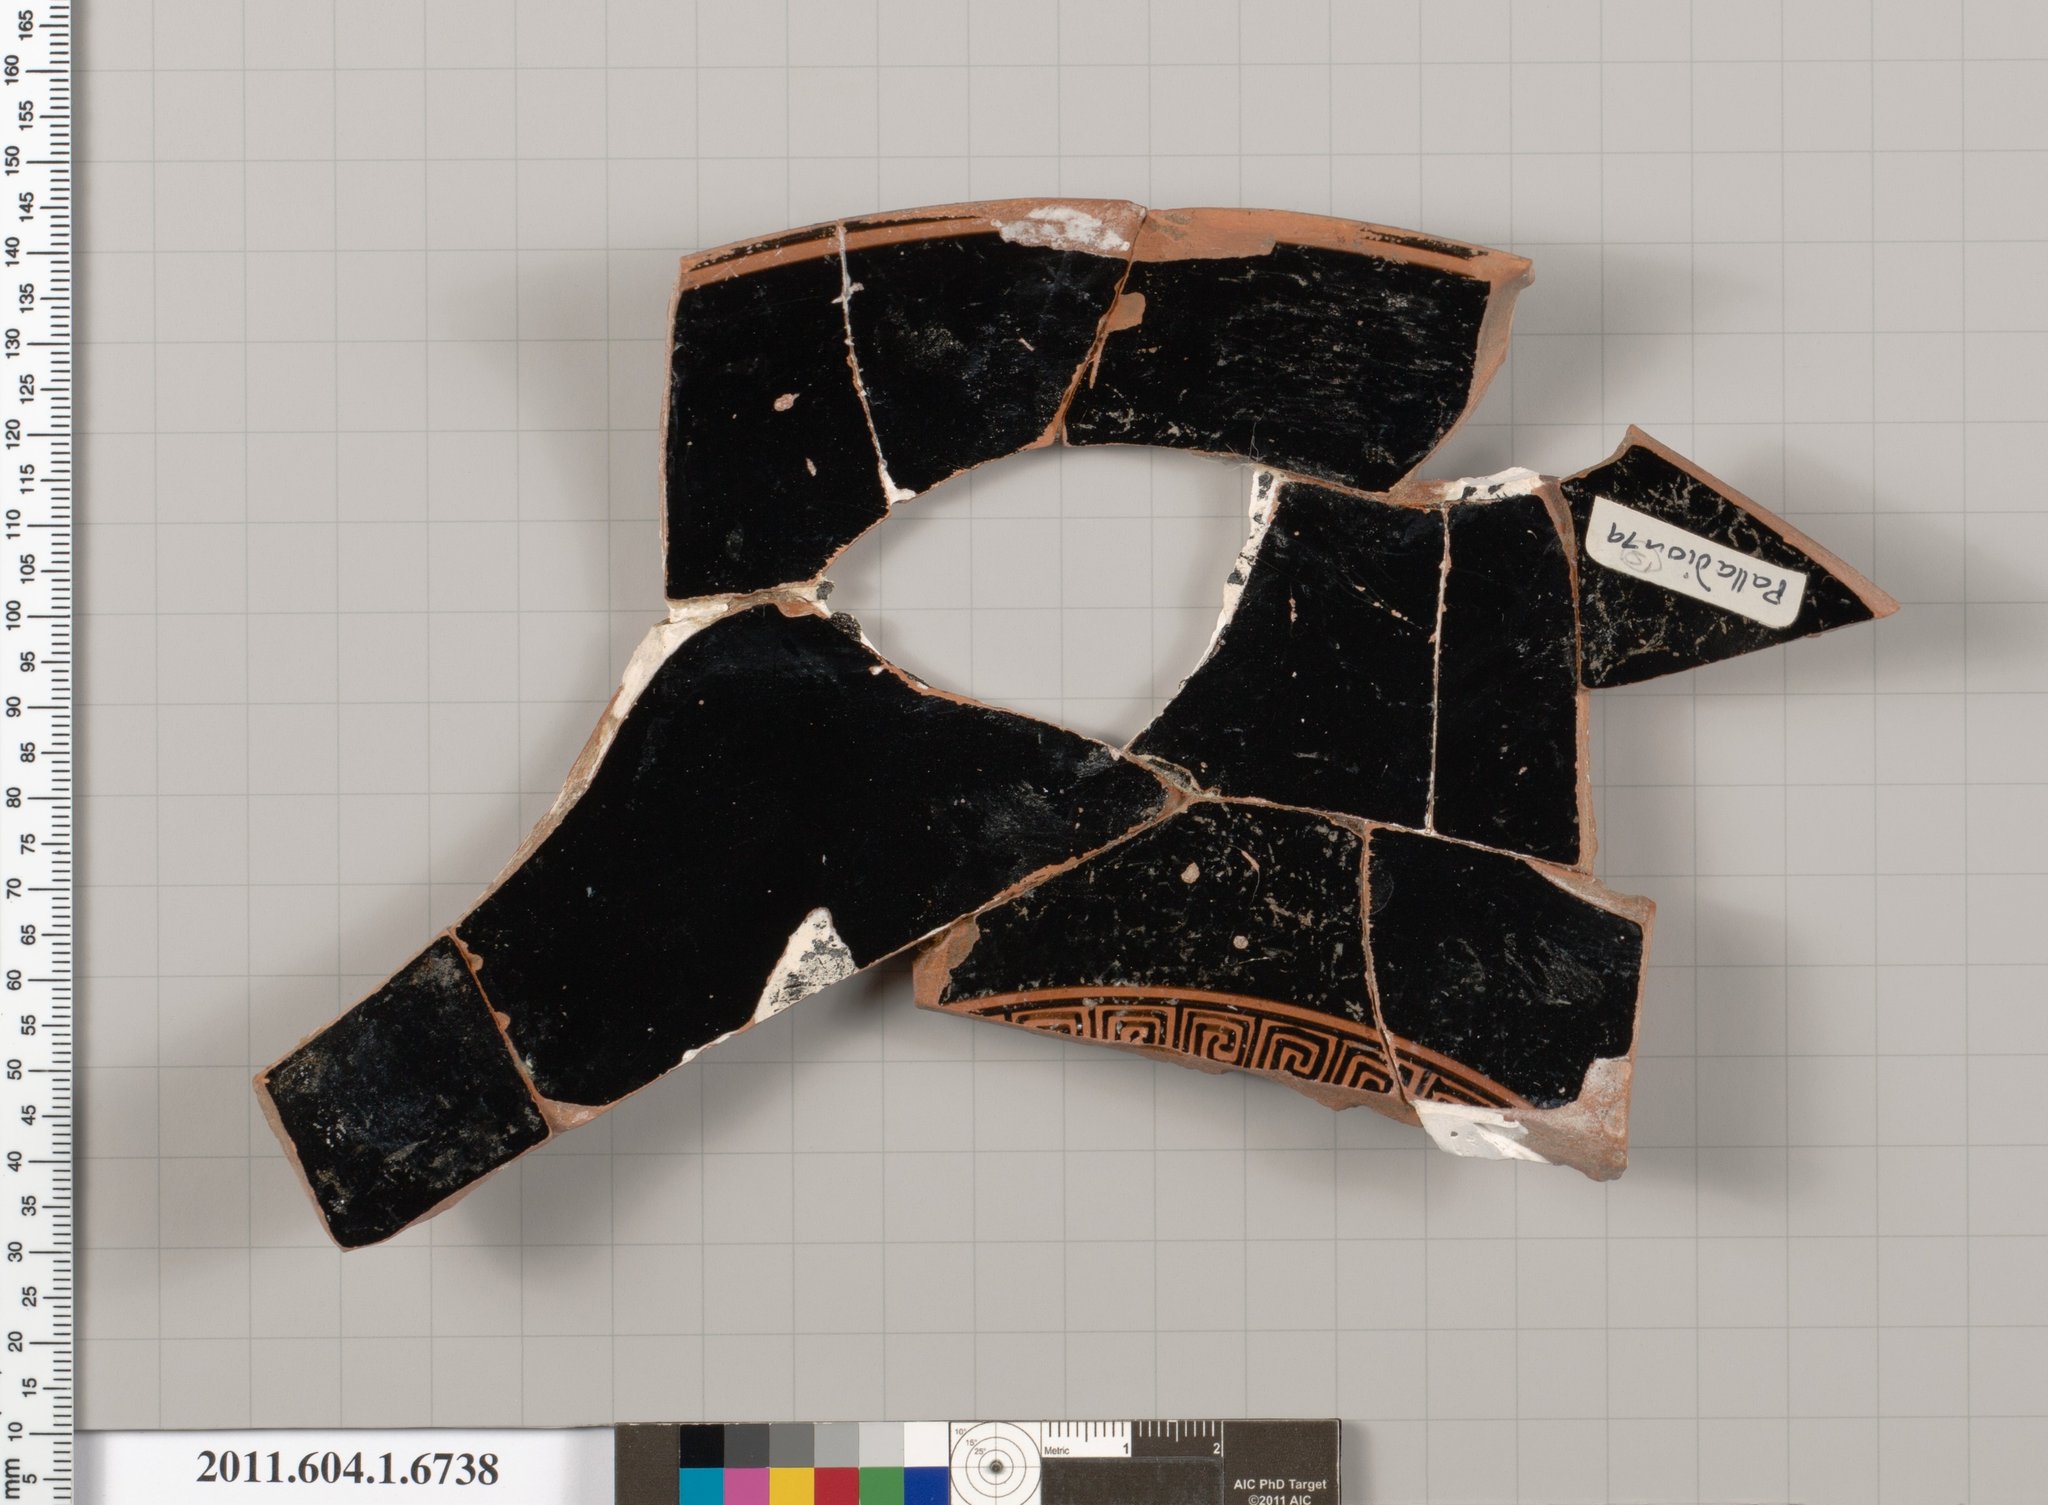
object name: kylix fragment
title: Terracotta fragment of a kylix (drinking cup)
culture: greek, attic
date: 490-470 BCE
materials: terracotta